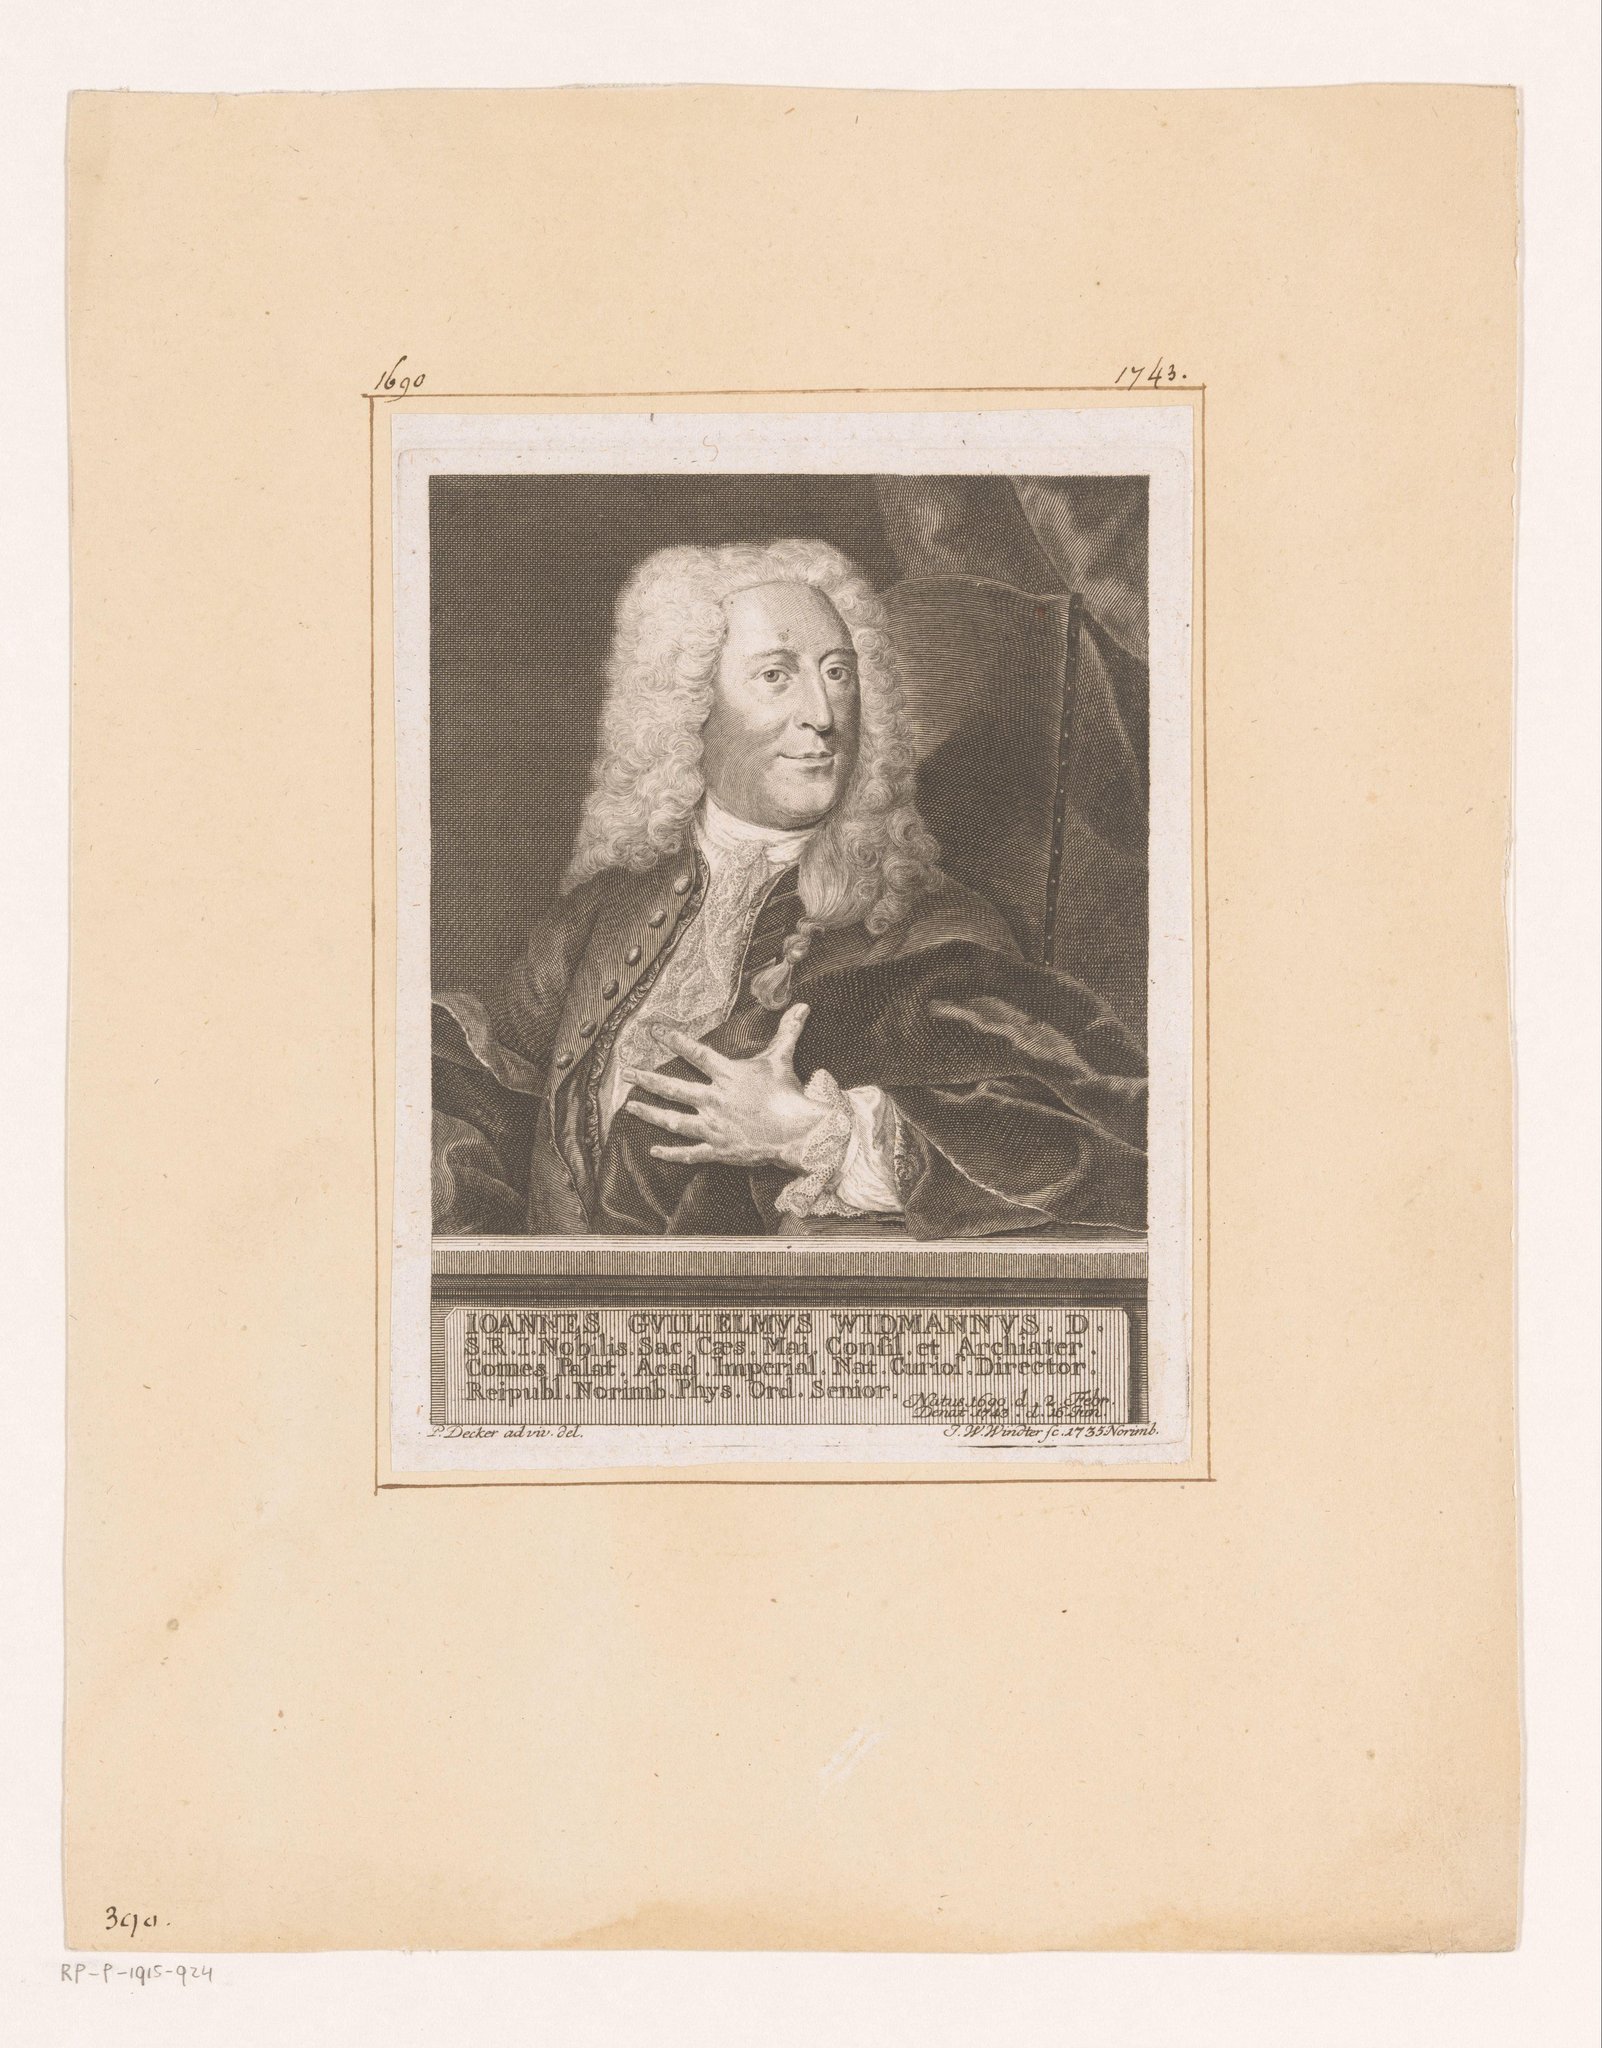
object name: print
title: Portret van Johann Wilhelm Widmann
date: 1735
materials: paper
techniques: engraving, etching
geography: nuremberg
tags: johann wilhelm widmann, historical persons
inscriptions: number: ‘390’, collector's mark: Lugt 2228, inscription: ‘1690 1743’